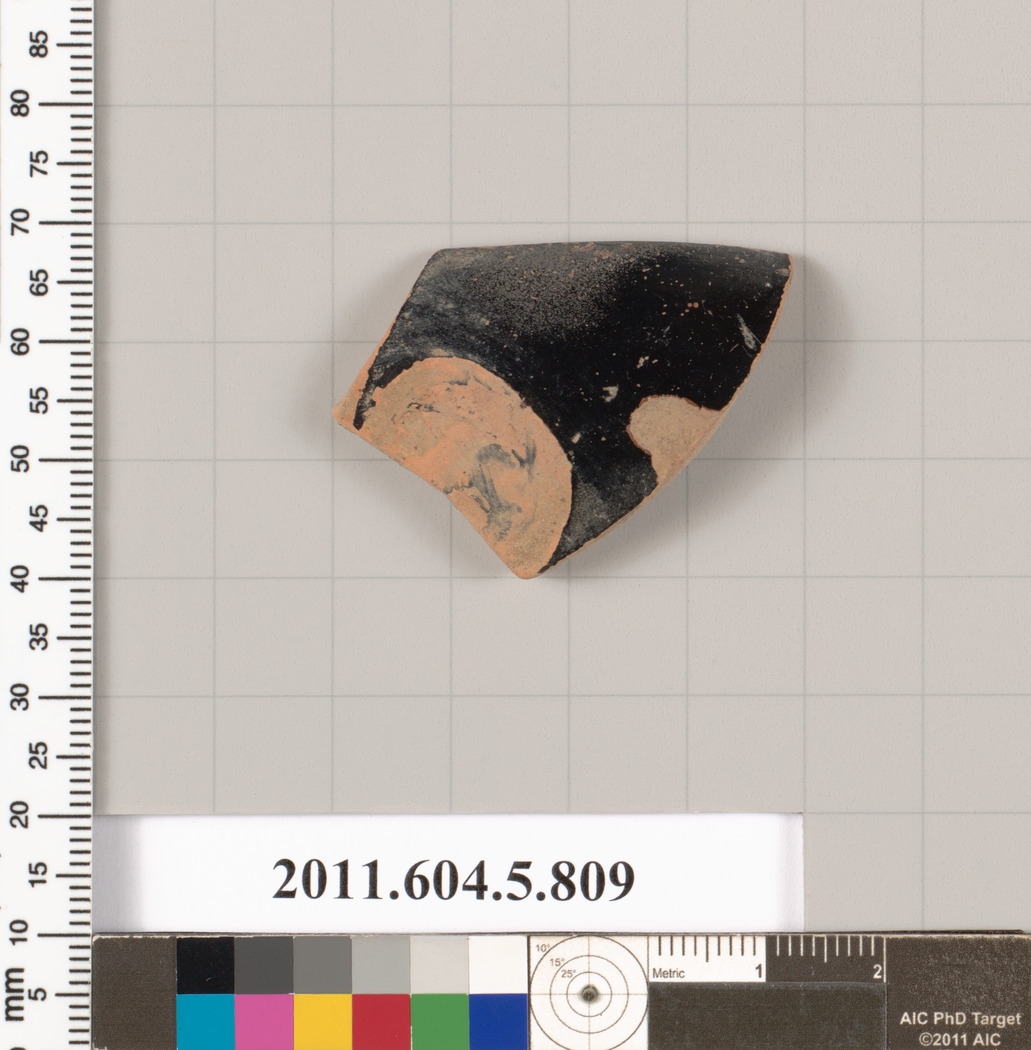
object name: kylix fragment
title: Terracotta rim fragment of a kylix (drinking cup)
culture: greek, attic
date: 600-401 BCE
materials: terracotta